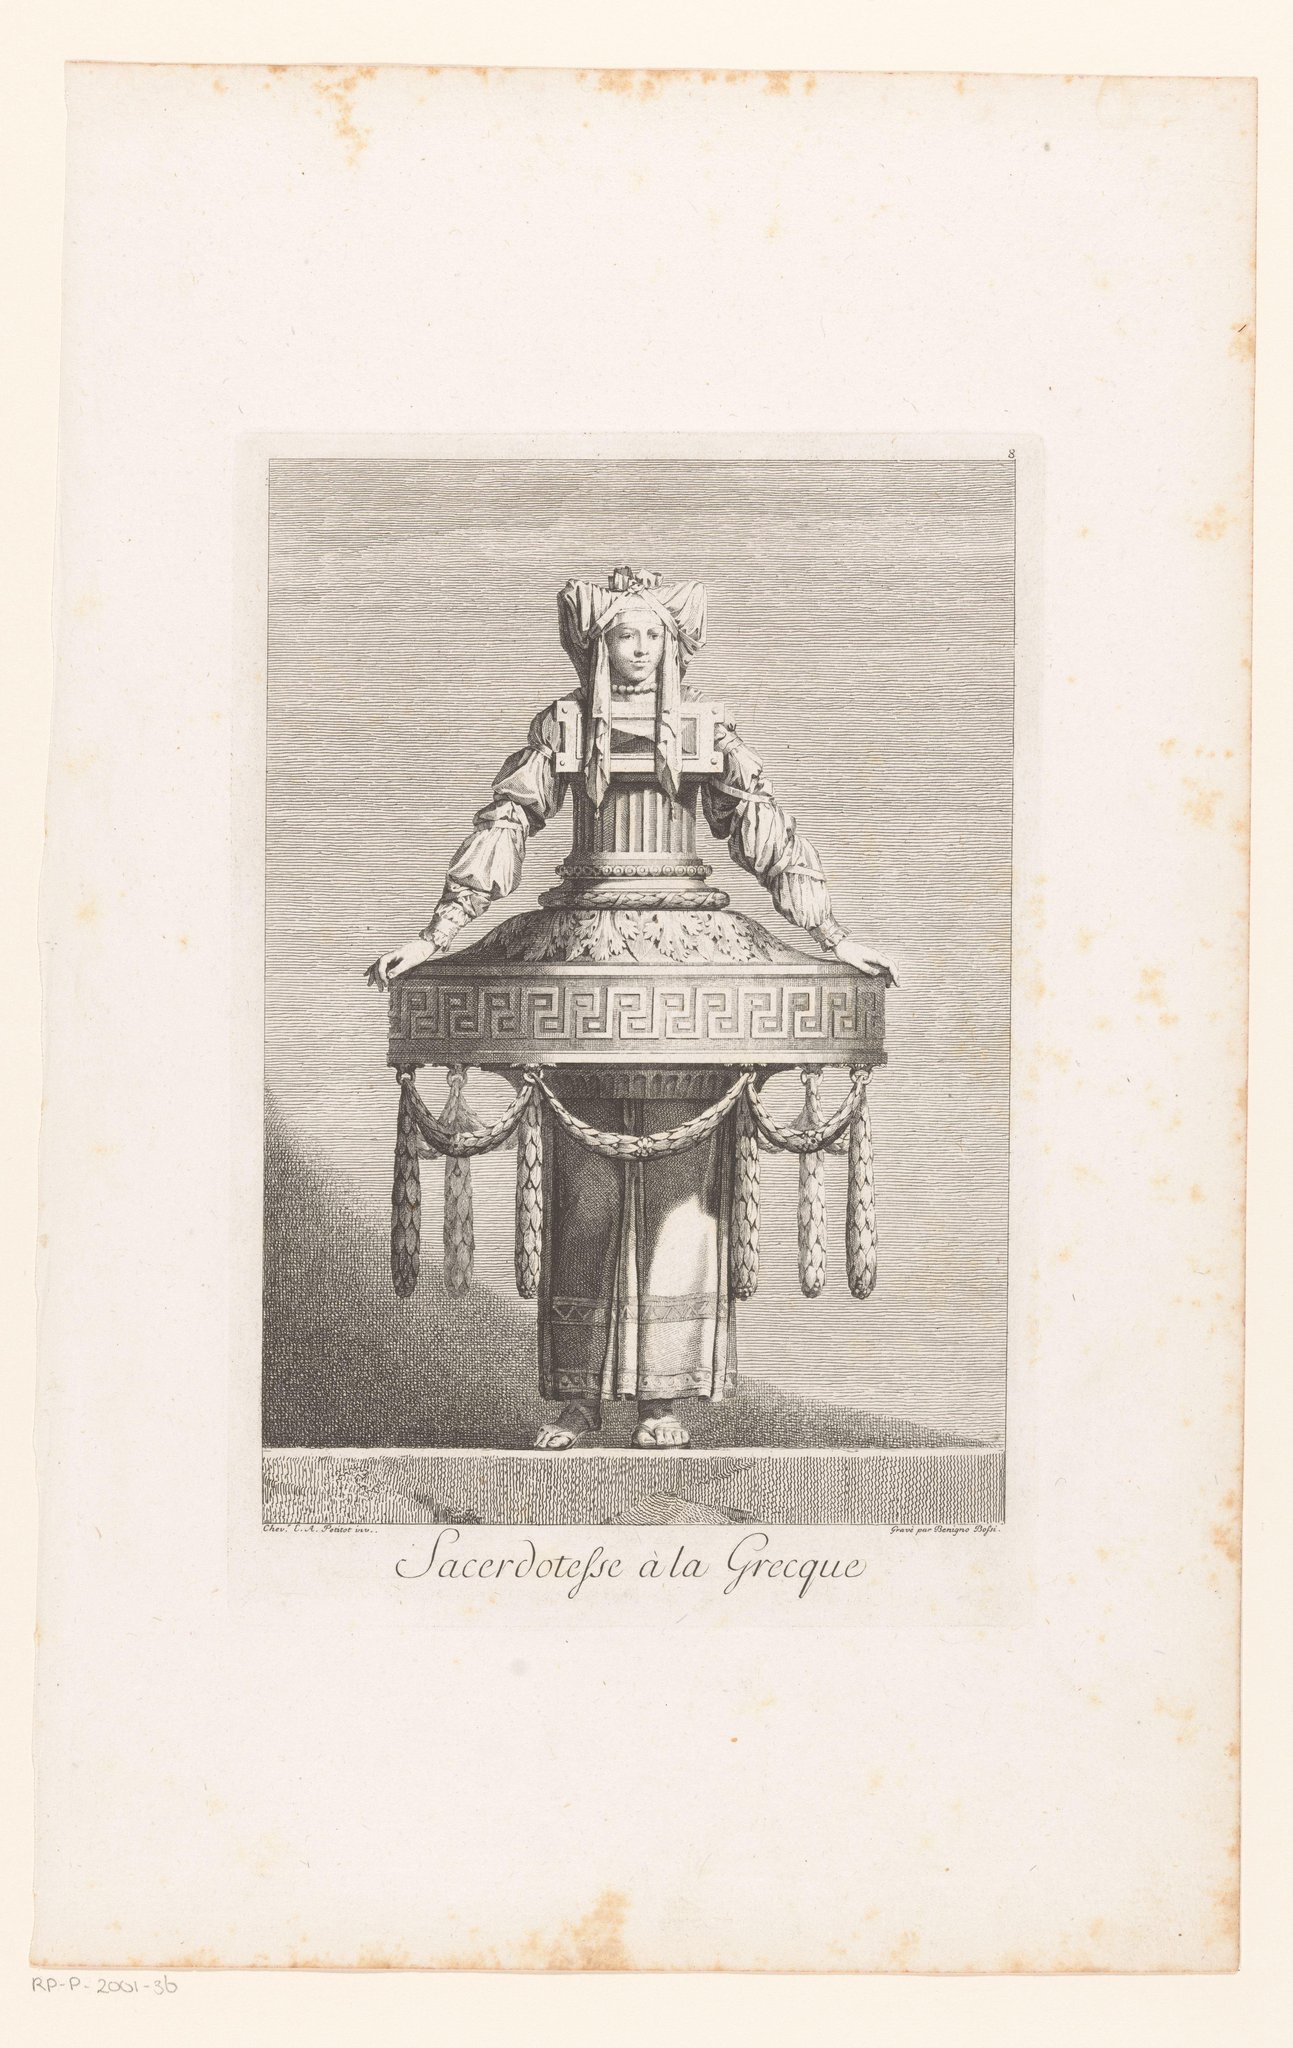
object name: print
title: Griekse priesteres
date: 1771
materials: paper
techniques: etching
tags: europeans, priest ~ greek religion - ee - priestess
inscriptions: collector's mark: Lugt 2228, collector's mark: Lugt 2760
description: Een staande vrouw met een bovenlijf als een gecanneleerde zuil en rond haar heupen een rond basement waaraan guirlandes hangen. Op haar hoofd draagt zij een hoofddeksel van doeken.